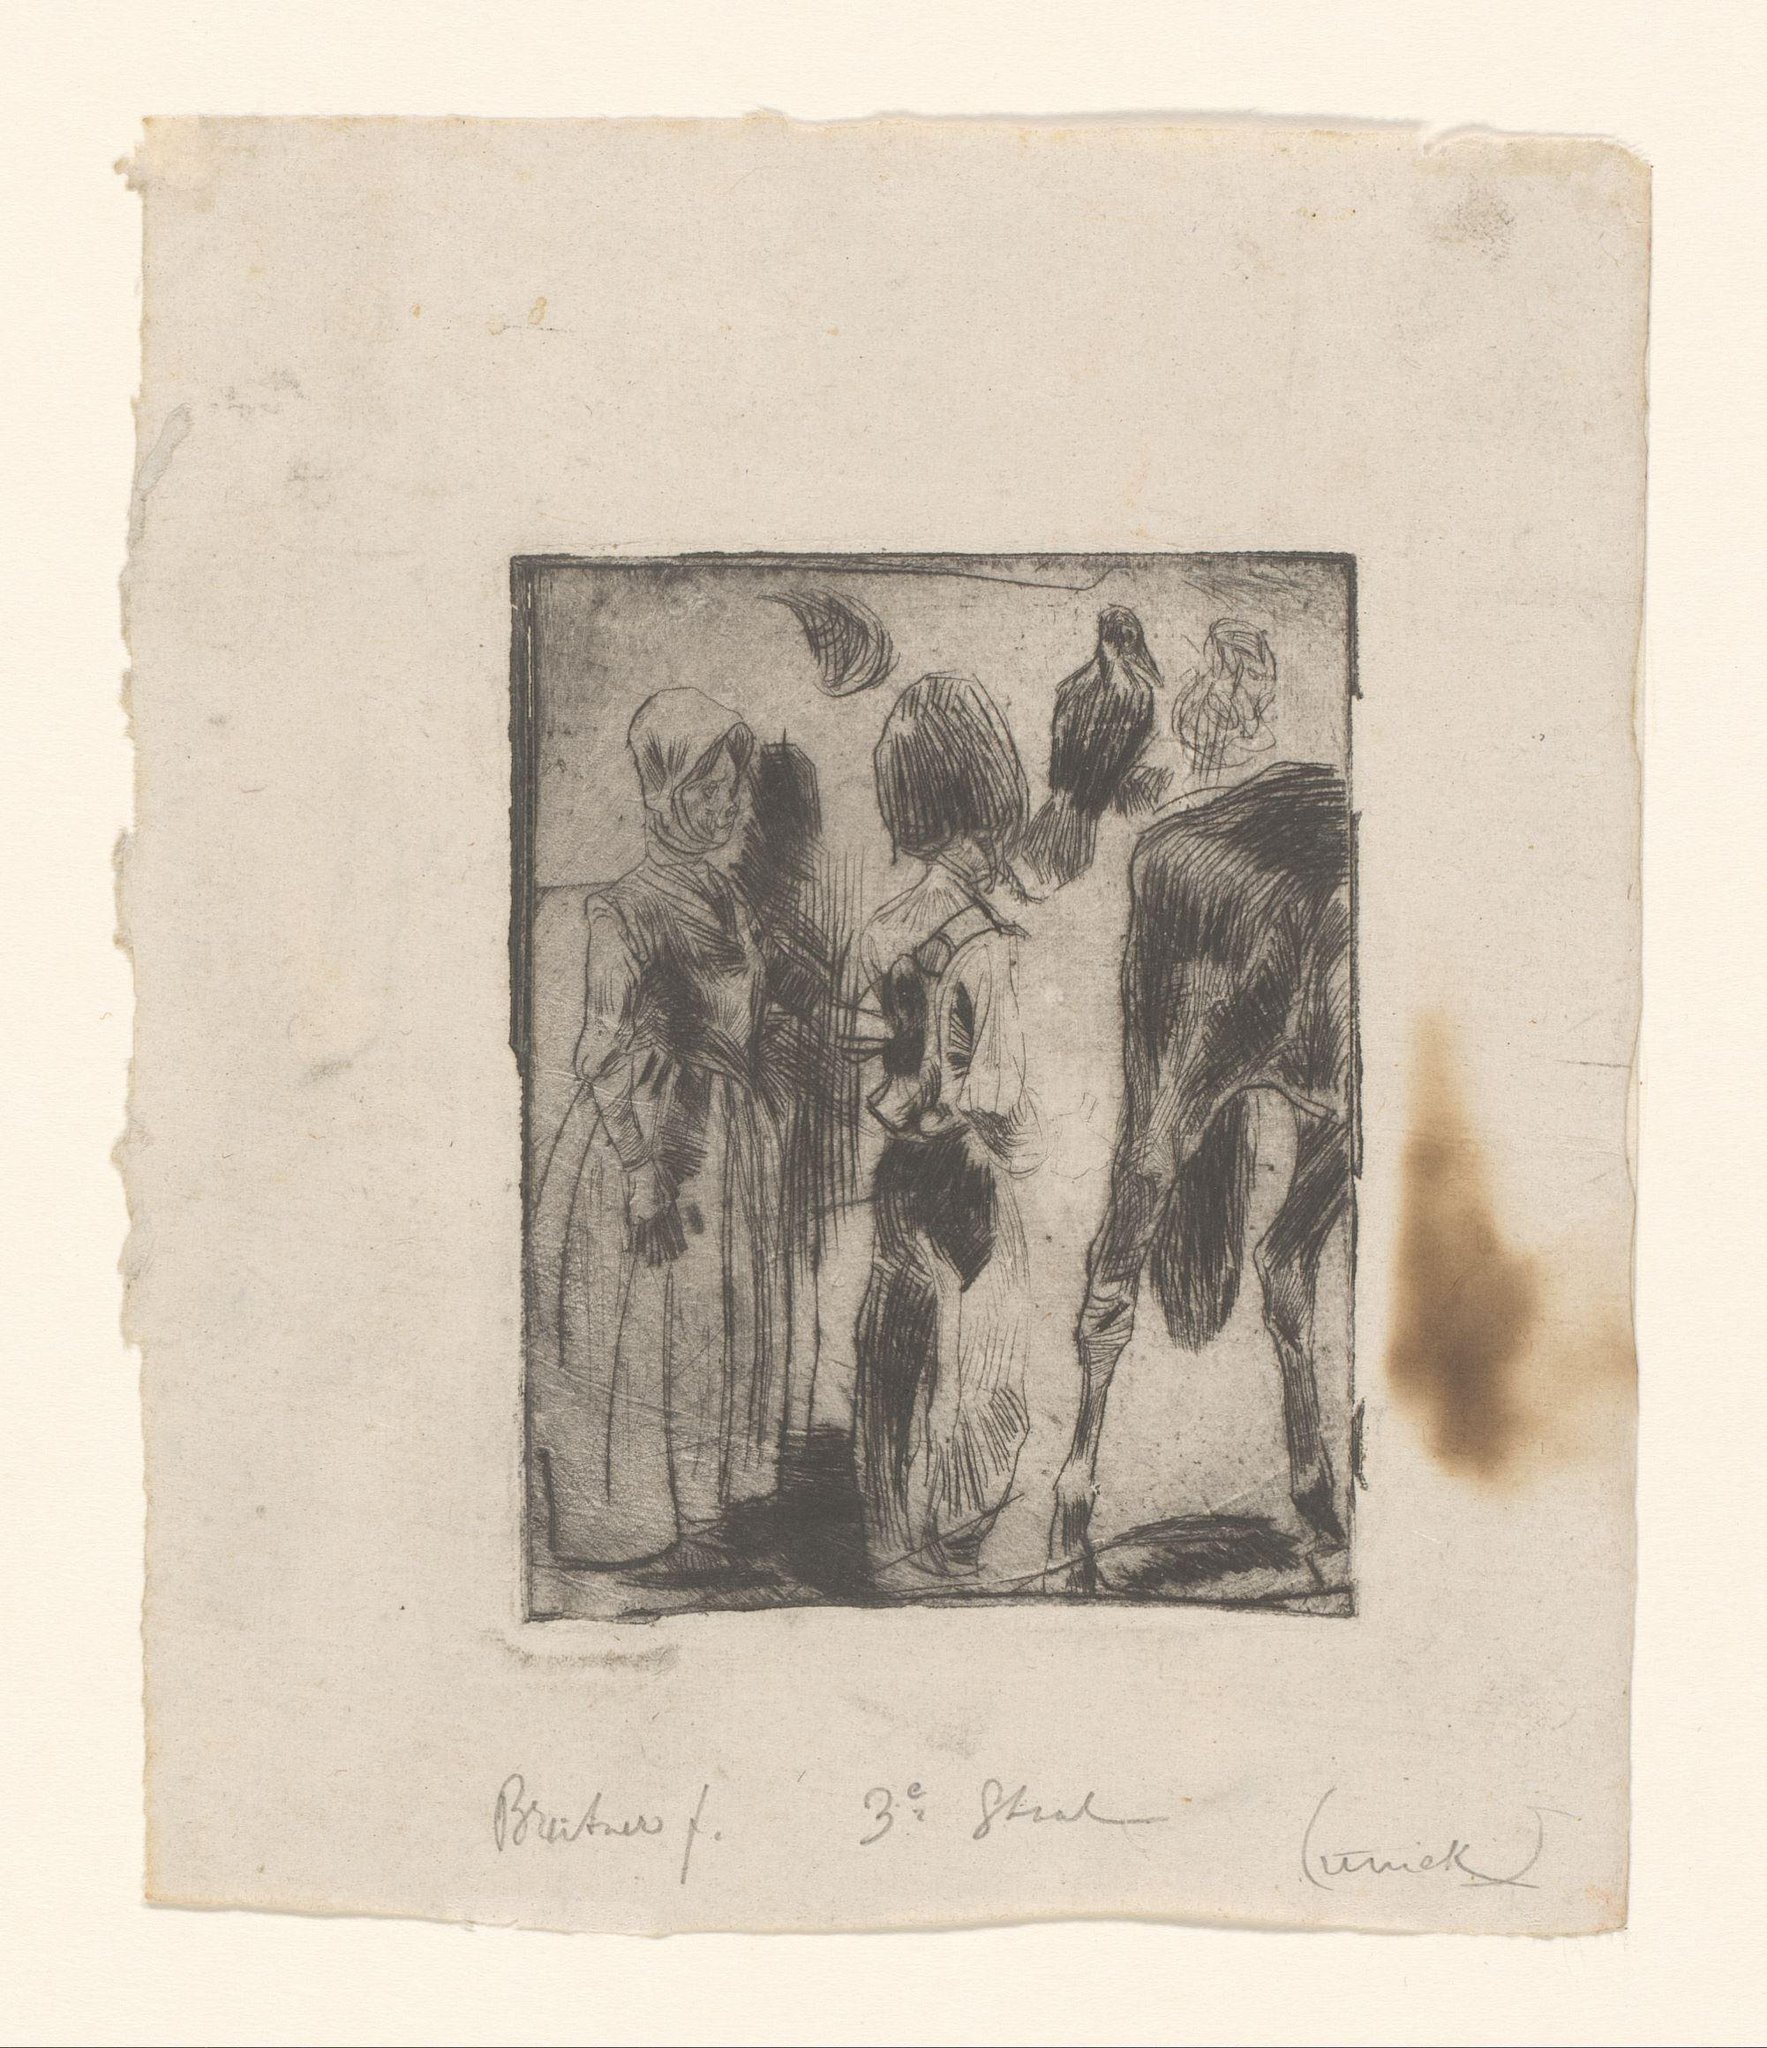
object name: print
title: Studieblad met huzaar, vrouw, paard en vogel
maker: george hendrik breitner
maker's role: draughtsman, painter, print maker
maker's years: 1857-1923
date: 1885-1887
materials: paper, ink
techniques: drypoint, intaglio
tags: the soldier; the soldier's life, horse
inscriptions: edition: ‘3e staat (uniek)’, collector's mark: Lugt 2233, signature: ‘Breitner f.’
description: Studieblad met een staande huzaar, een vrouw met hoofddeksel, de achterkant van een paard en een vogel.